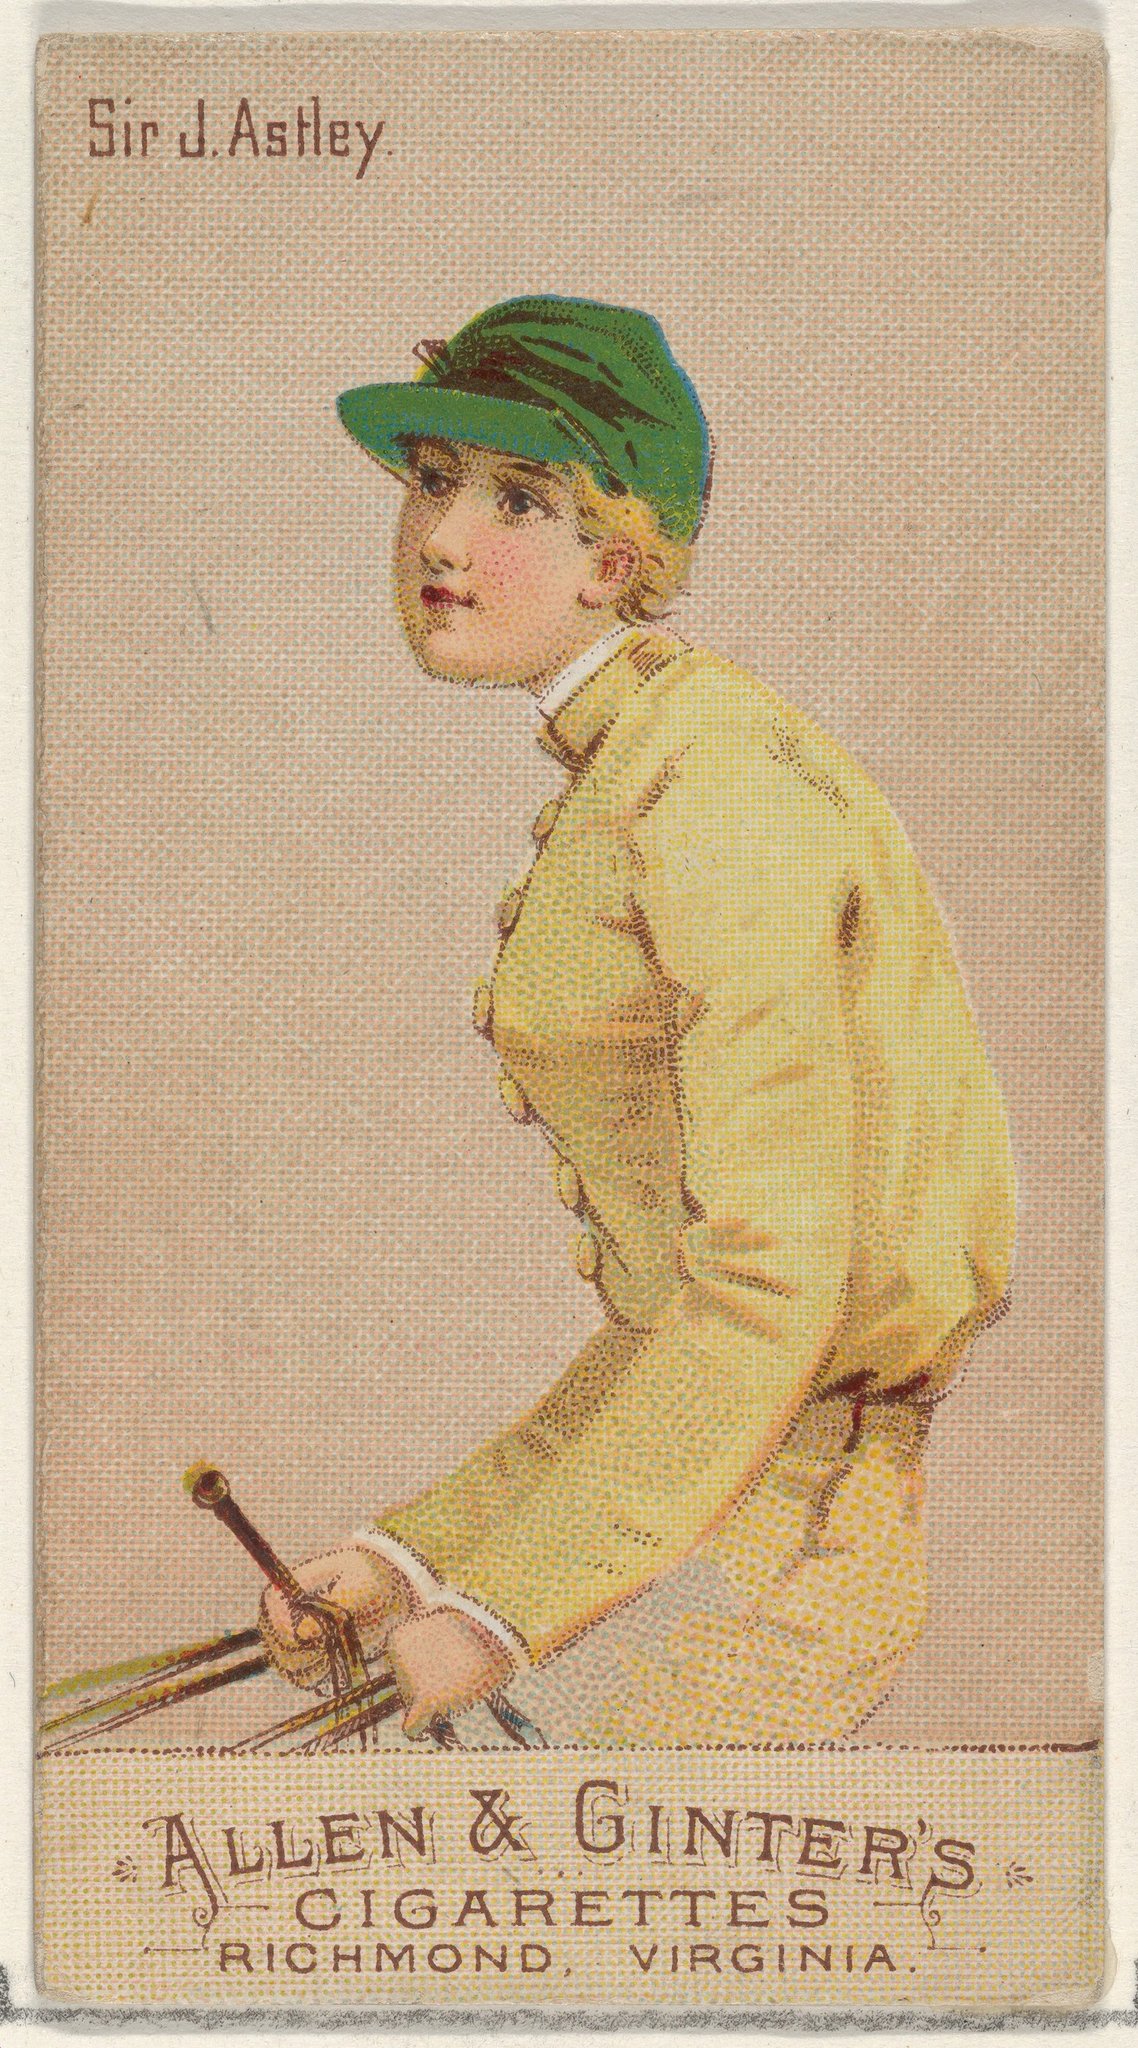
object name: print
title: Sir J. Astley, from the Racing Colors of the World series (N22b) for Allen & Ginter Cigarettes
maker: allen & ginter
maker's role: publisher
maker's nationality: american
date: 1888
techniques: color lithograph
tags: women,jockeys